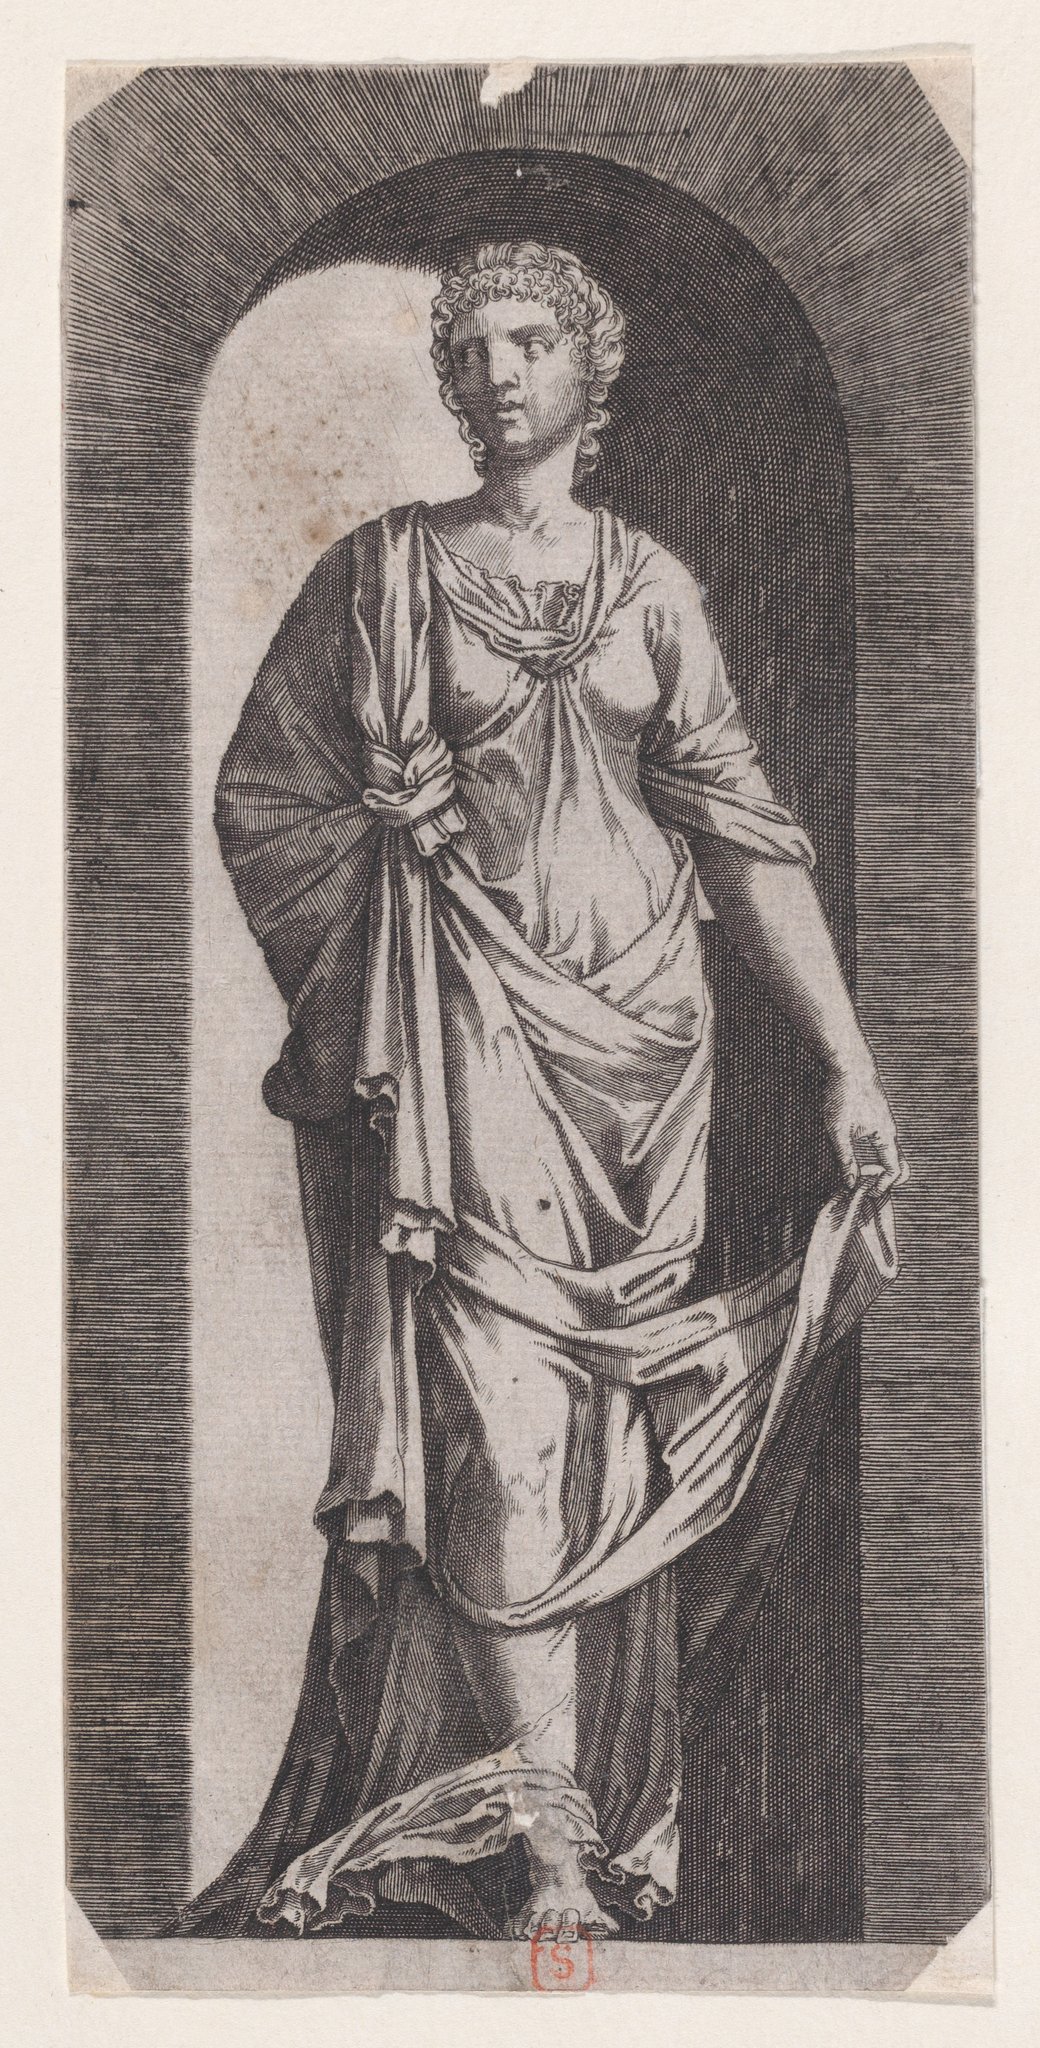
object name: print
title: Sibyl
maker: lambert suavius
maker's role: artist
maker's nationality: netherlandish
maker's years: 1510-1576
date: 1530-1576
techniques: engraving